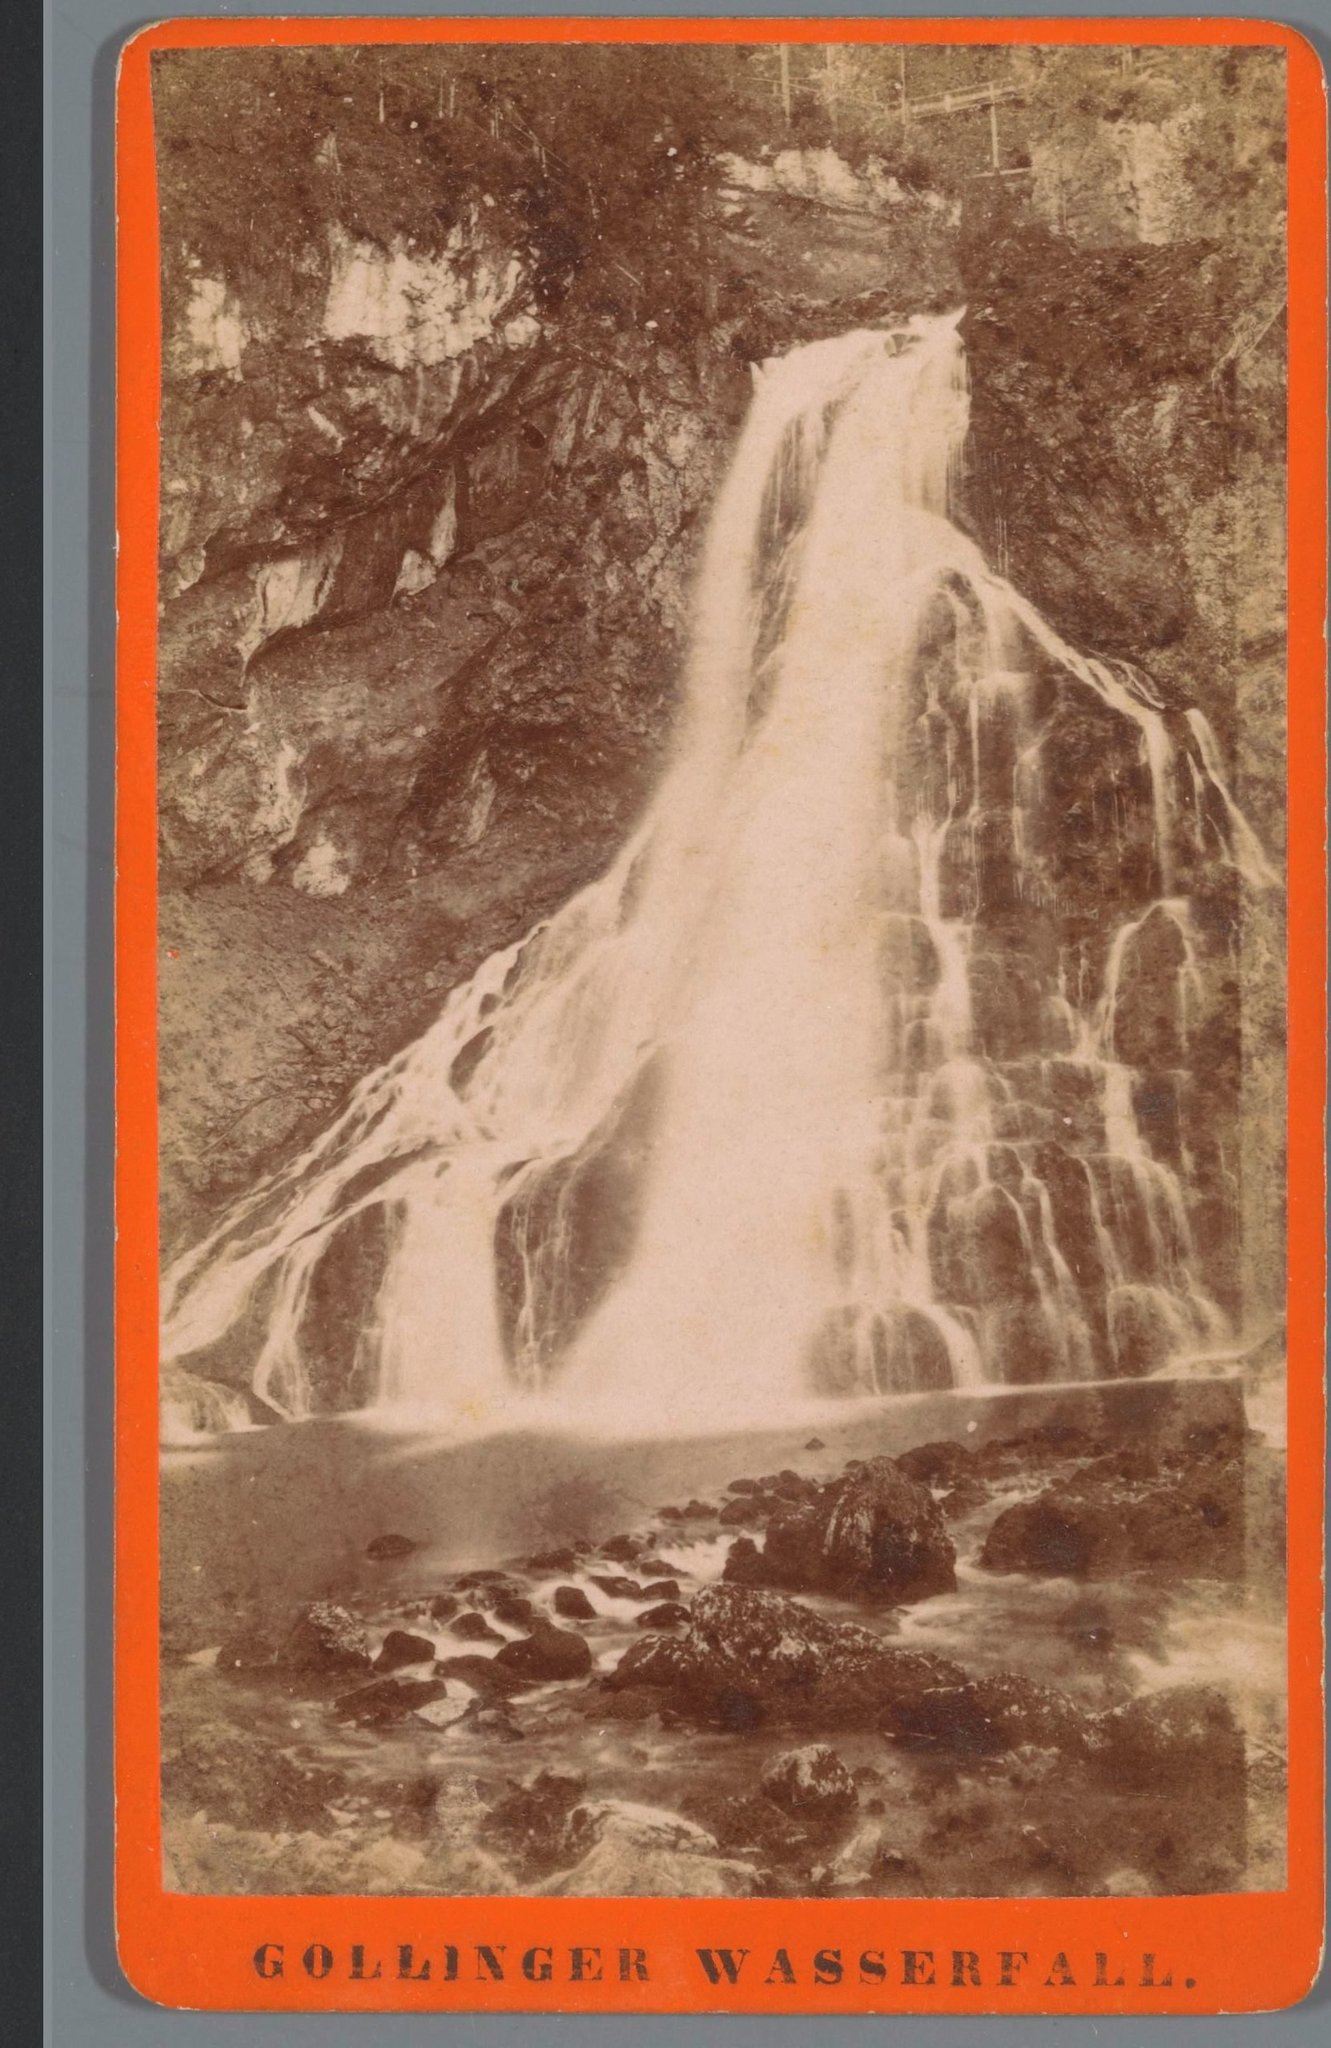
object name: photograph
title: Gollinger Wasserfall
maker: Anonymous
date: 1855-1885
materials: cardboard, paper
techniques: albumen print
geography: golling an der salzach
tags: waterfall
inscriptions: inscription: ‘Golling/ (Oostenrijk)’